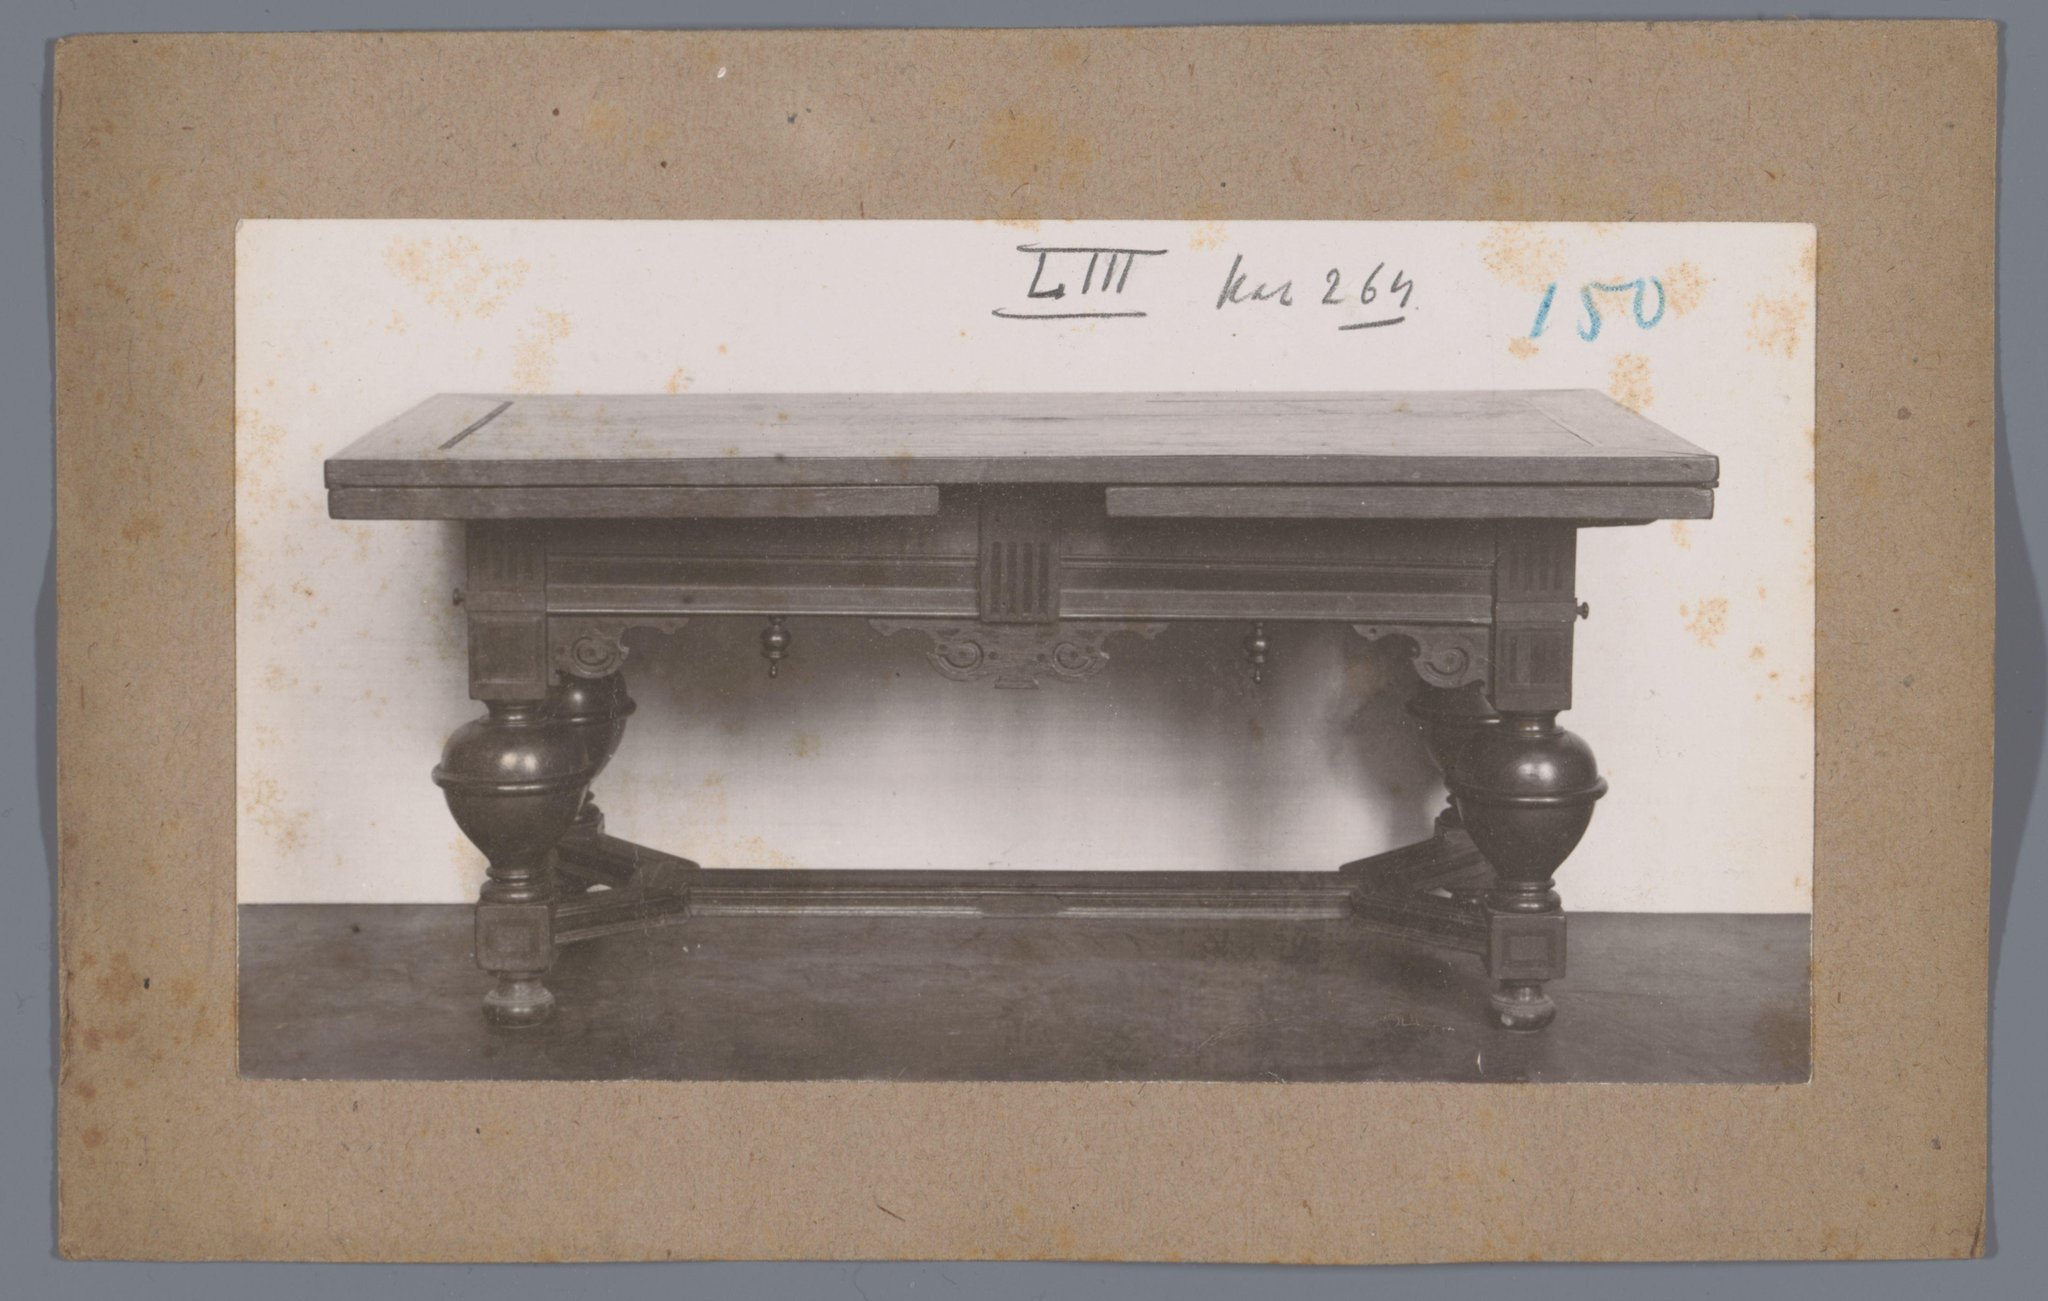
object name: photograph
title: Trektafel (vermoedelijk) in het Rijksmuseum te Amsterdam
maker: Anonymous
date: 1875-1900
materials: photographic support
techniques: matte daylight collodion silver print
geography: amsterdam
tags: table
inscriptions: number: ‘LIII kat 264 150’, collector's mark: ‘Kunstnijverheidschool Quellinus Amsterdam Frans Halsstraat 14.’, collector's mark: ‘Instituut voor kunst-nijverheidsonderwijs Gabriël Metsustraat No. 16, Amsterdam’